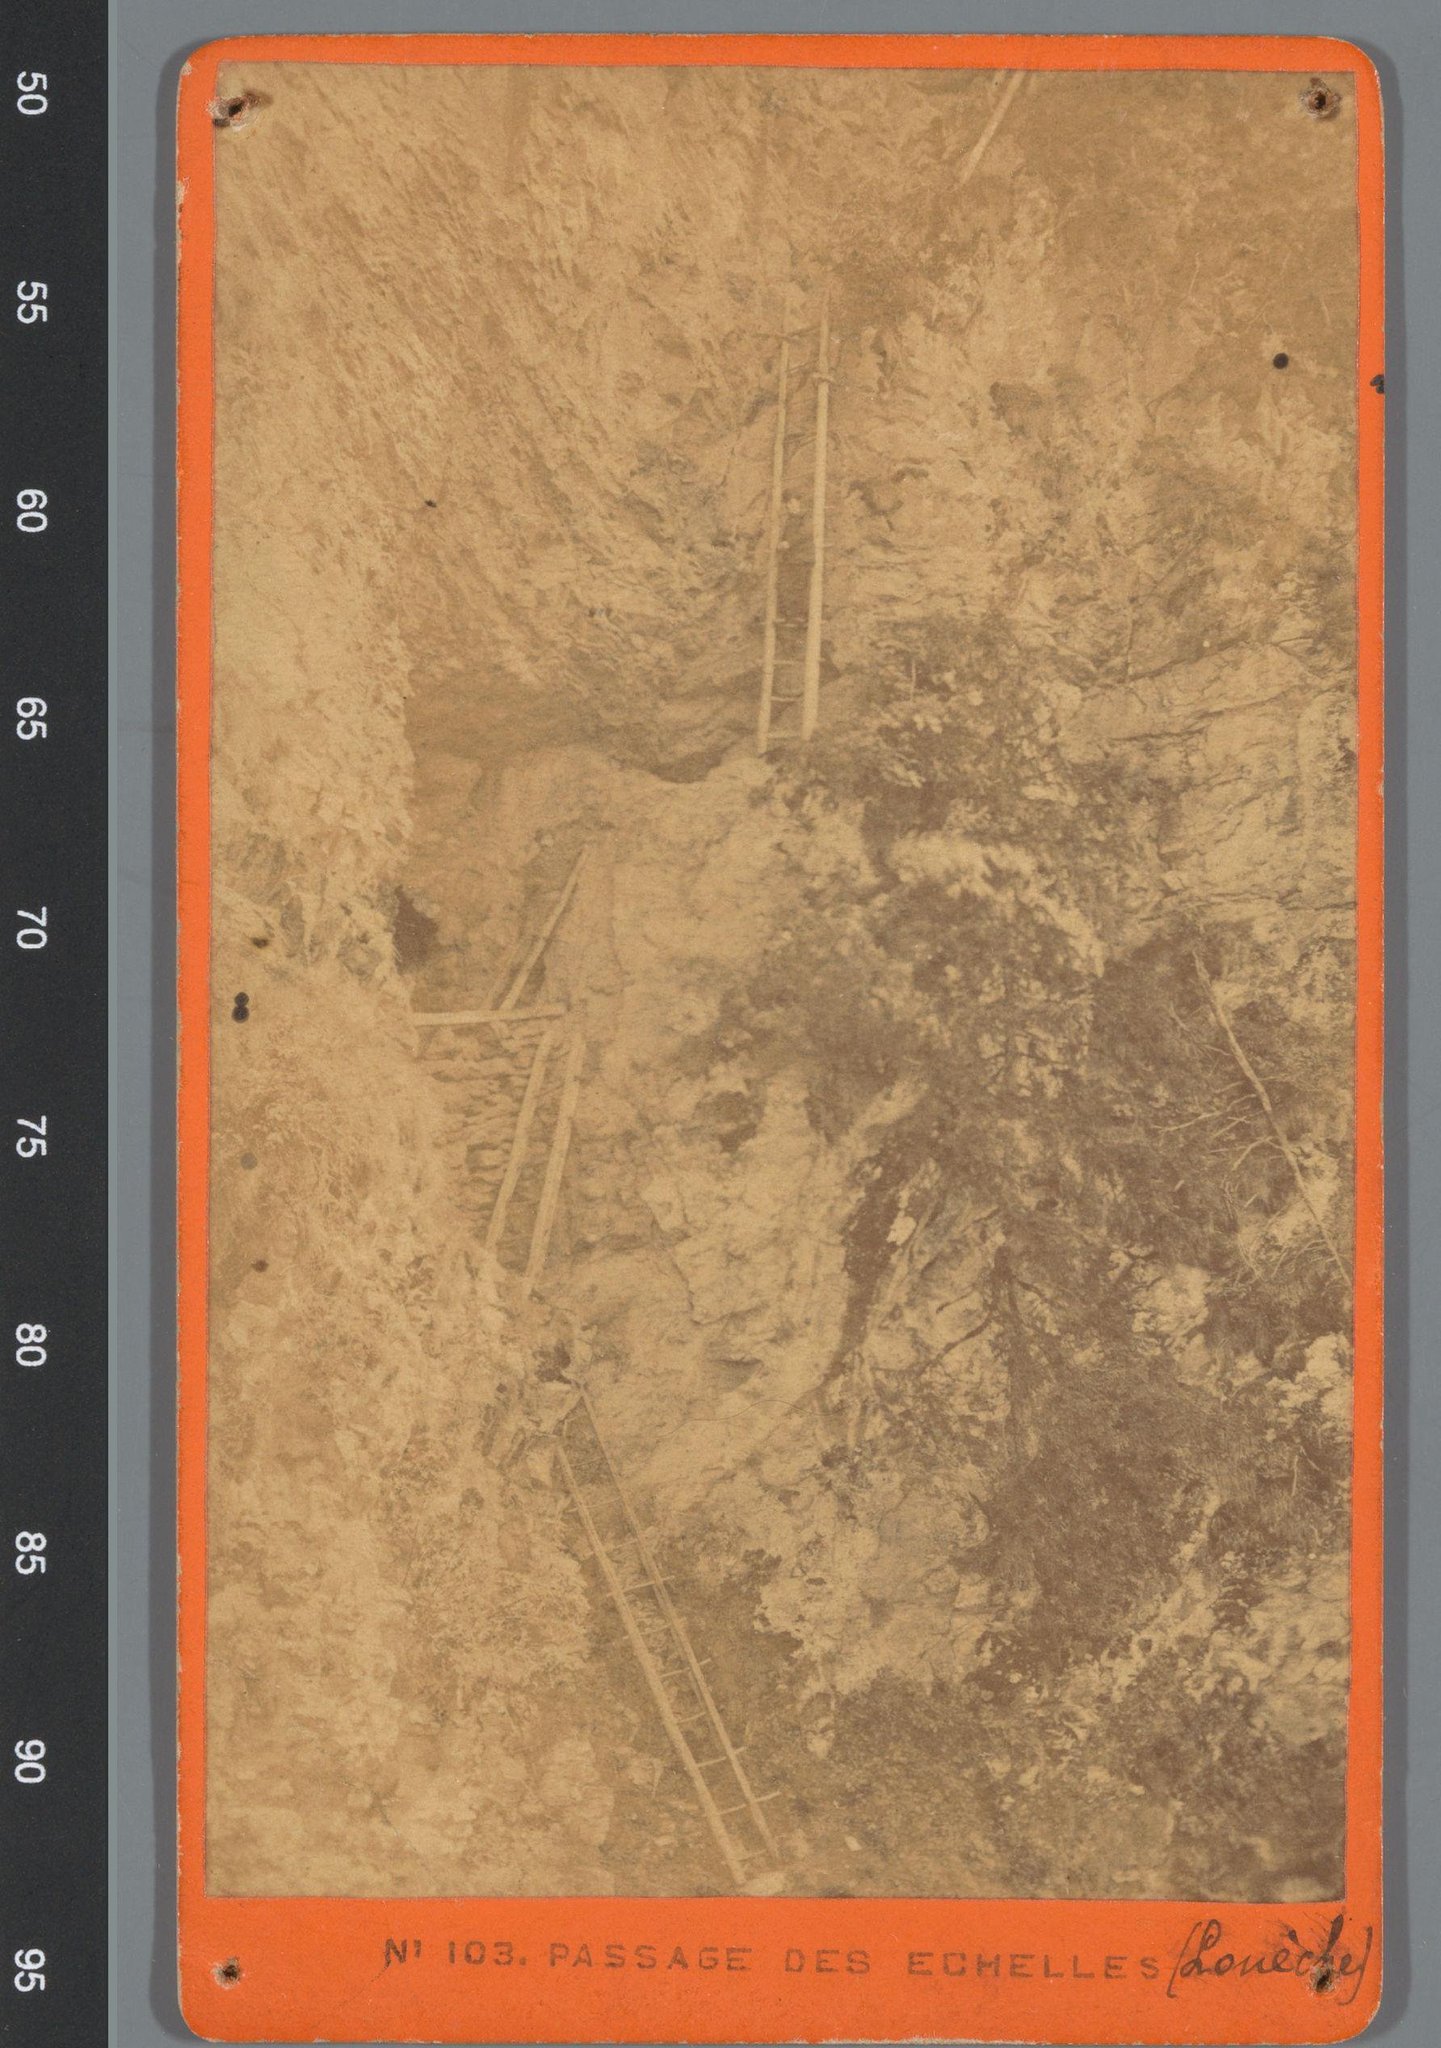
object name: photograph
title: Passage des Echelles (Louèche)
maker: florentin charnaux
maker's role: publisher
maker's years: 1819-1883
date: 1878-1883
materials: cardboard, paper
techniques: albumen print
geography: leukerbad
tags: mountain climbing, mountaineering, ladder, mountains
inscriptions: inscription: ‘Maison des Trois Rois/ F. Charnaux/ Genève’, number: ‘No 103’